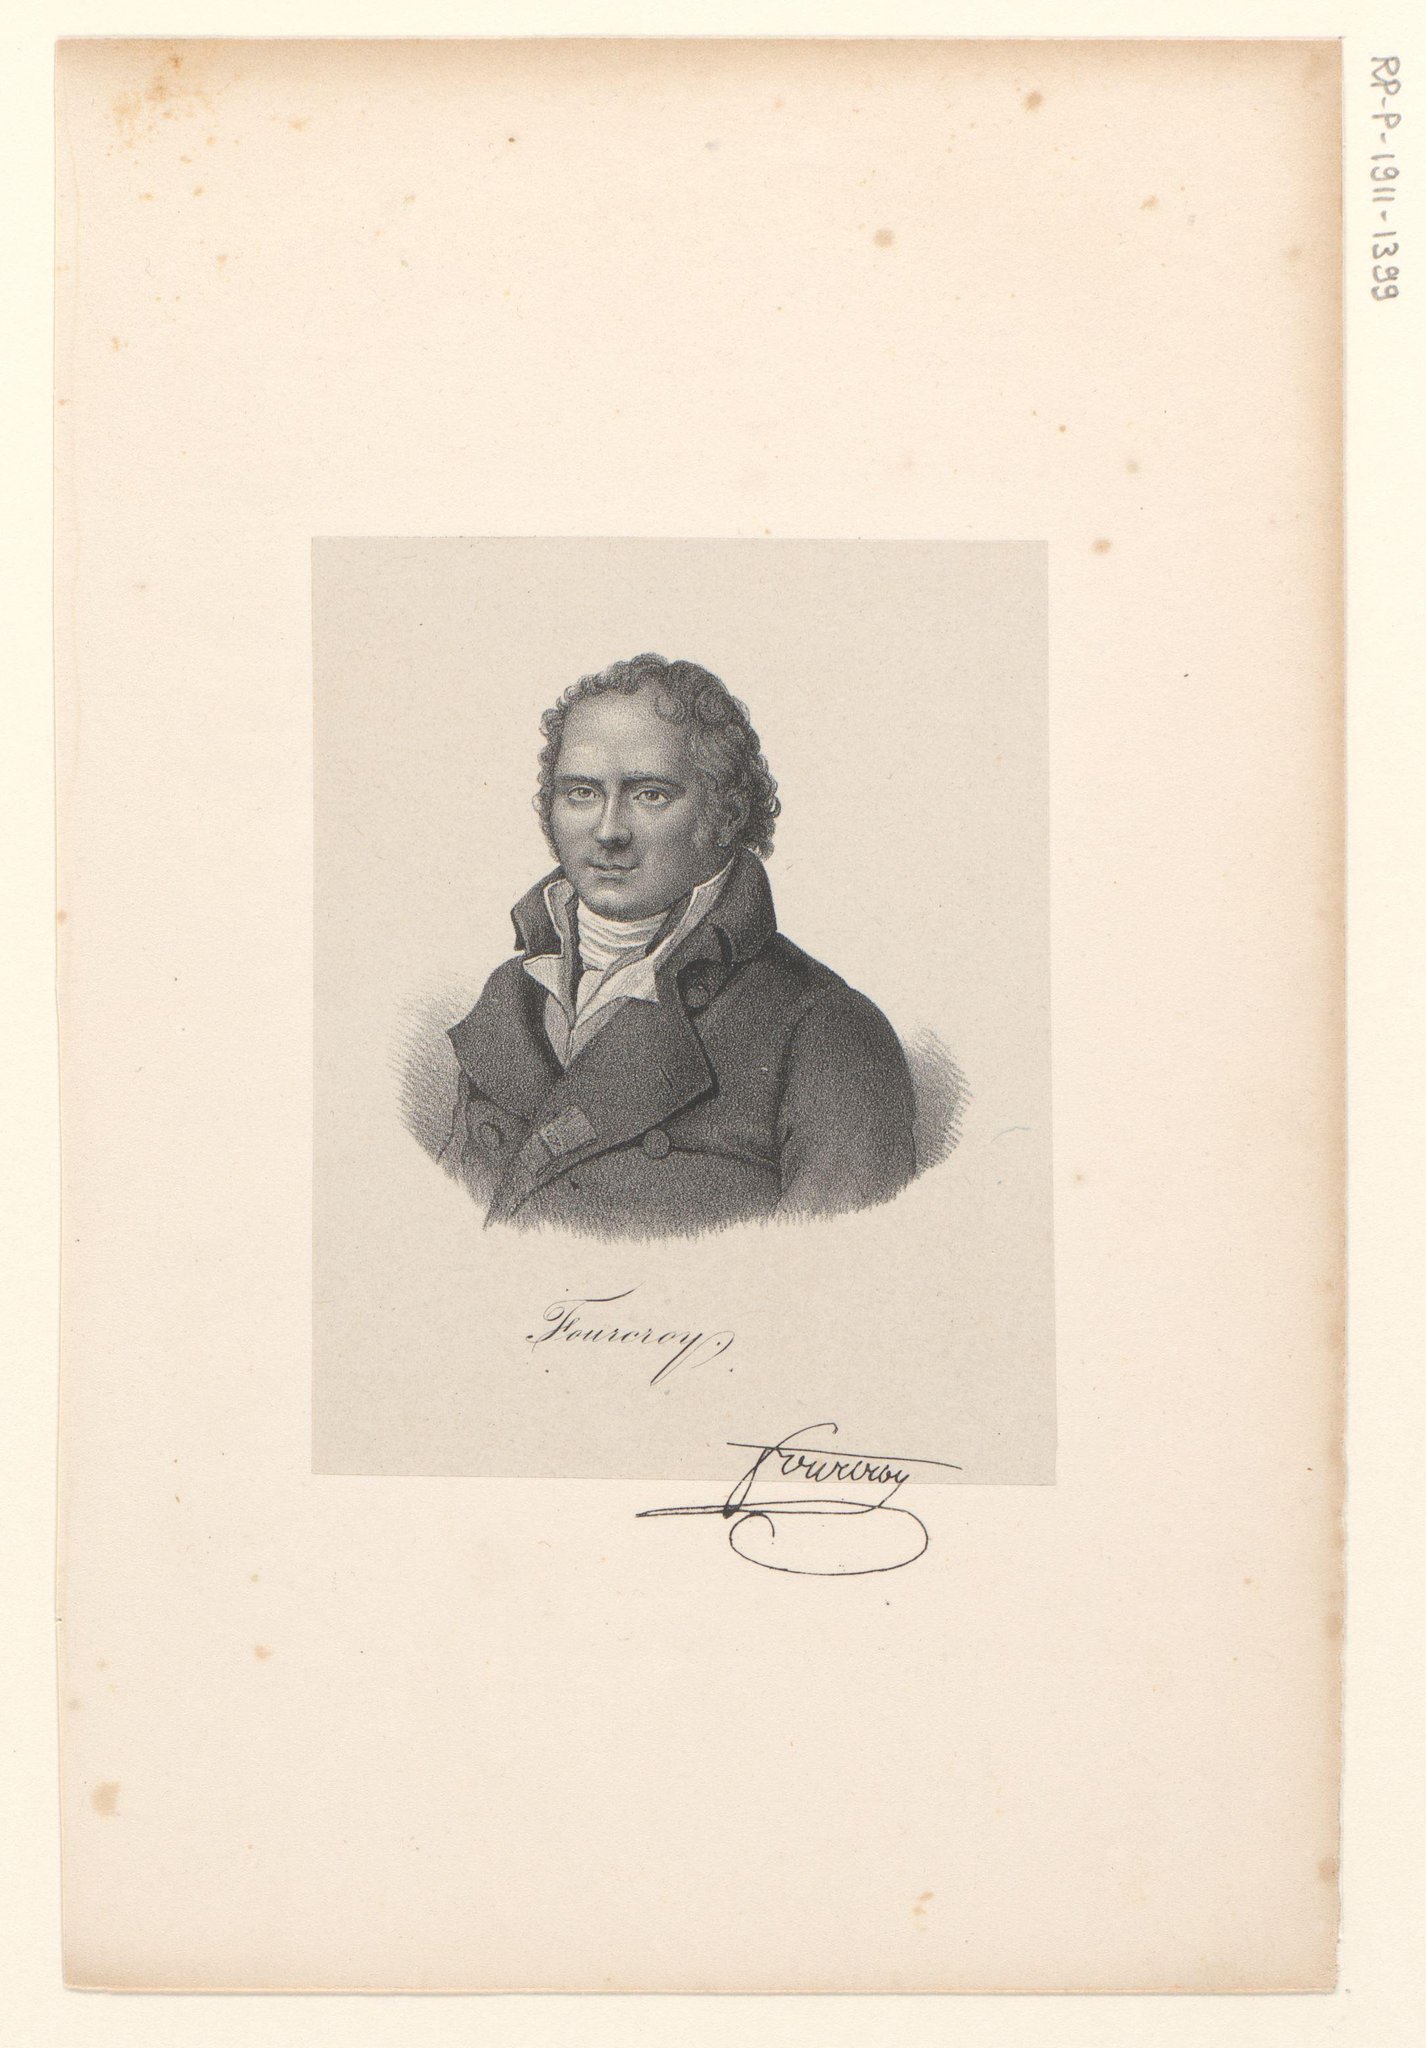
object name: print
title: Portret van Antoine François de Fourcroy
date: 1818-1842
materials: paper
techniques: lithograph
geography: paris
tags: paris, historical persons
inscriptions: collector's mark: Lugt 2228a